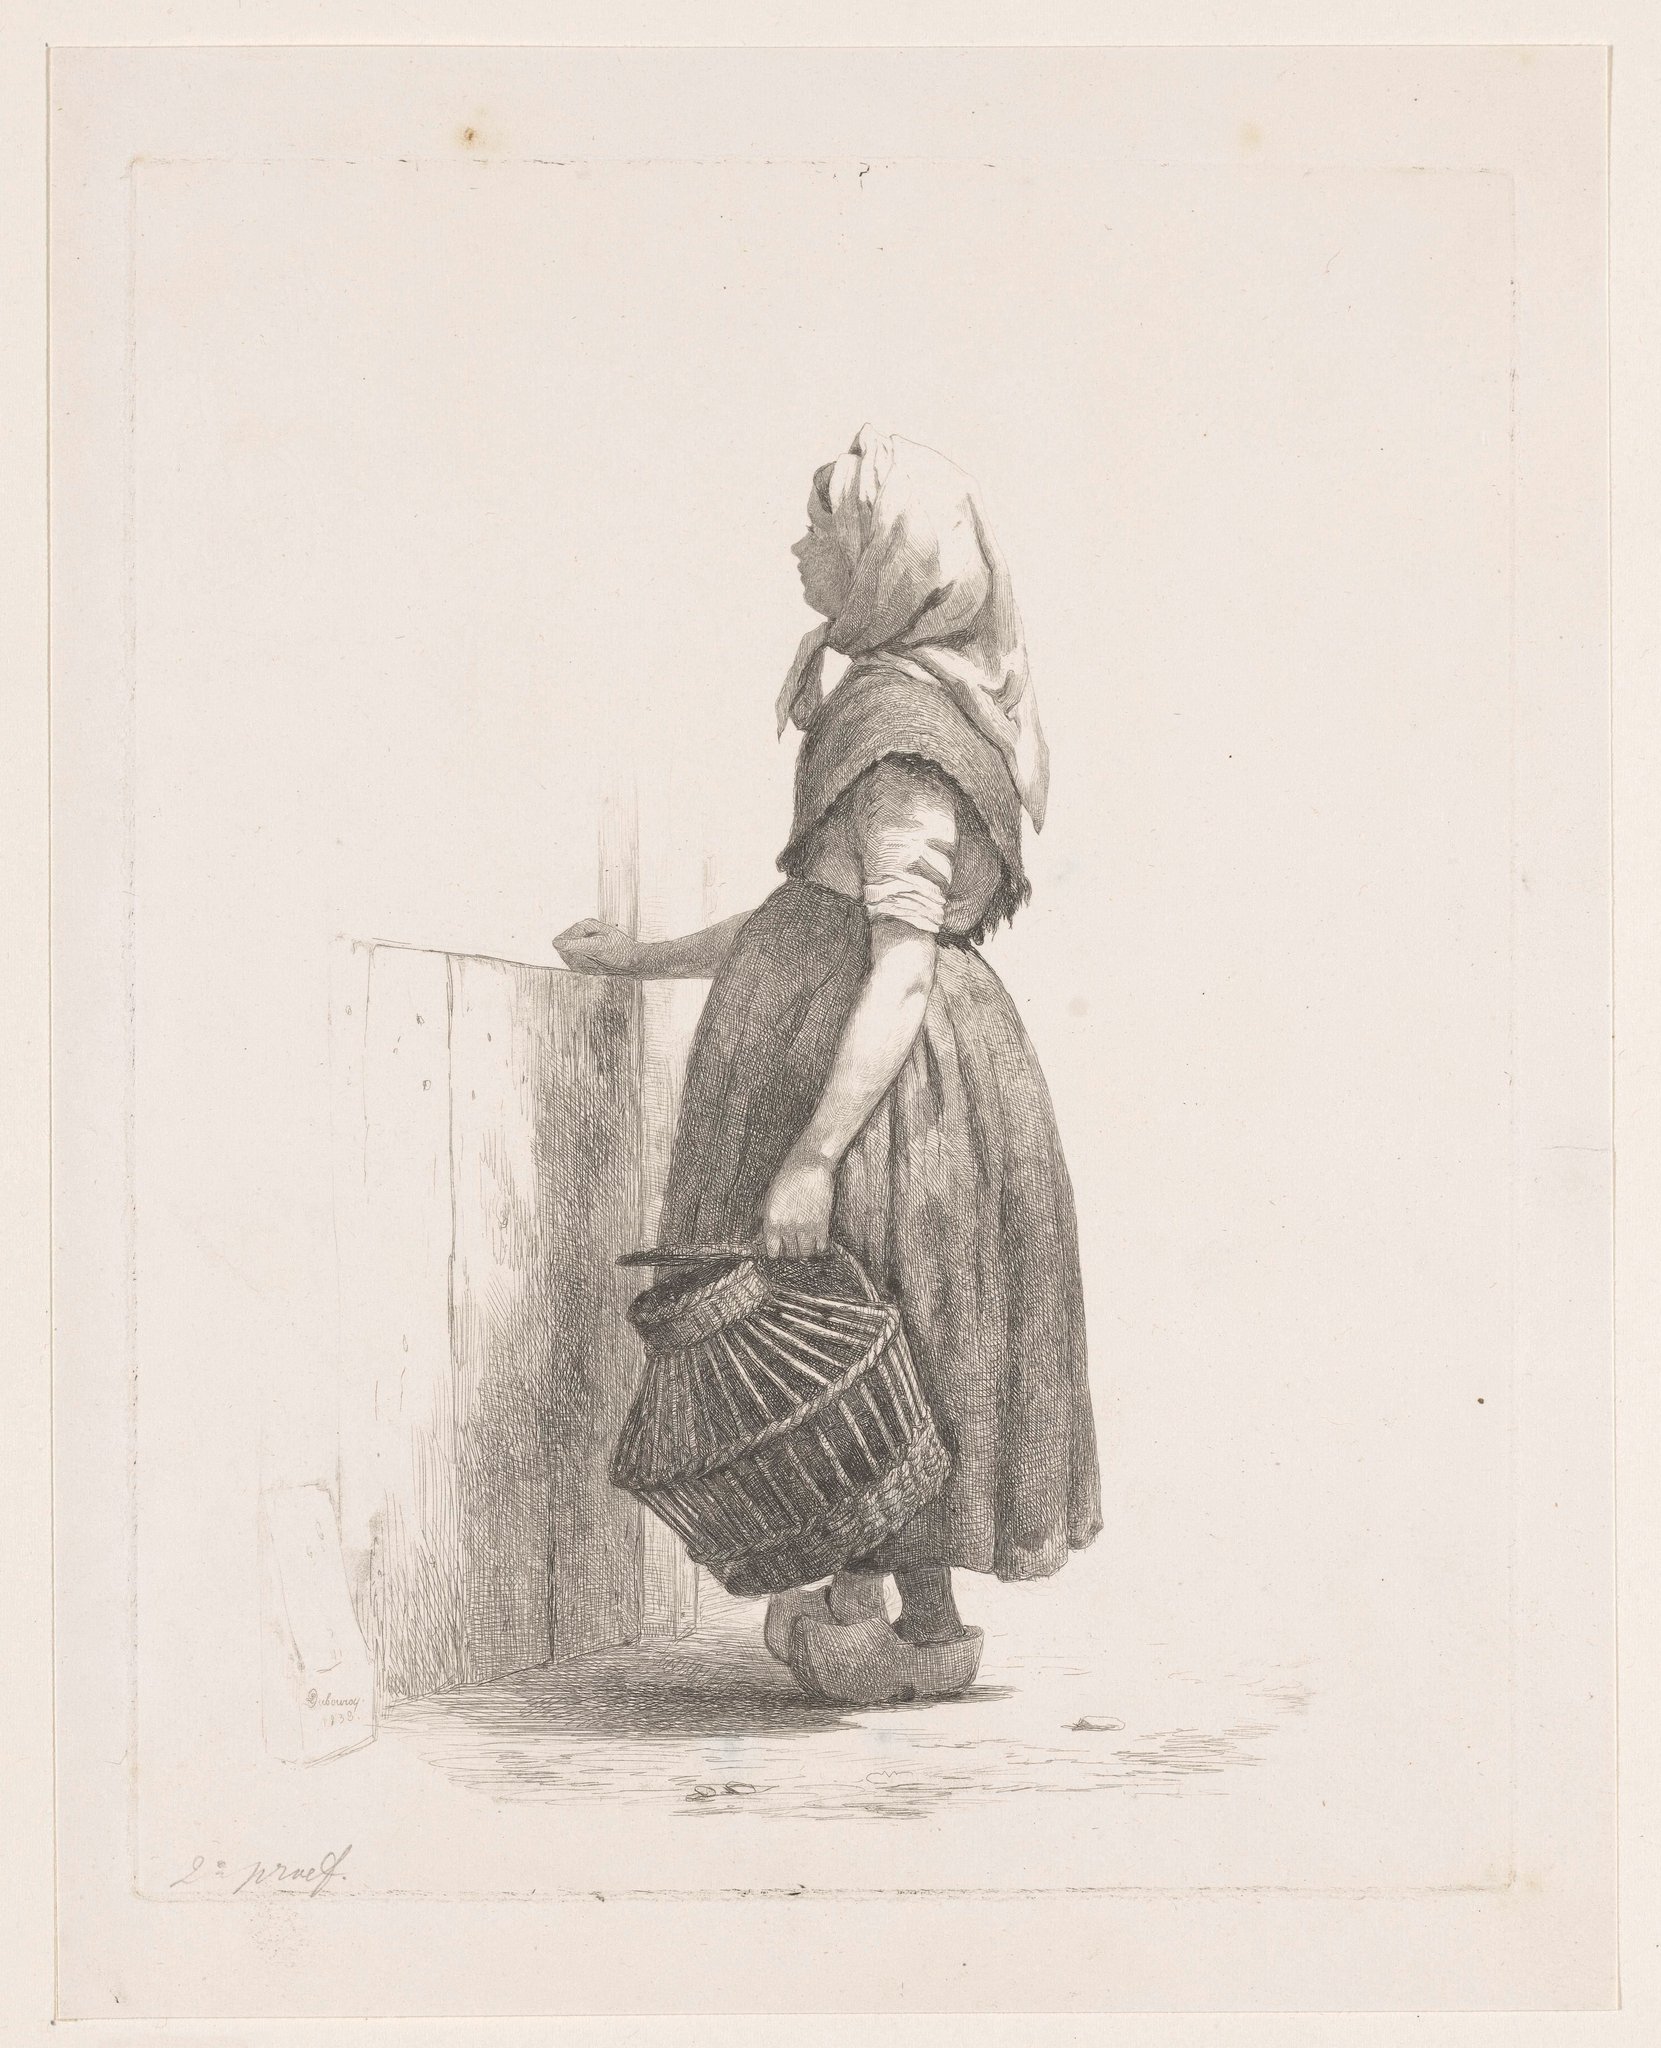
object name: print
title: Staand meisje met pluimveemand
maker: pierre louis dubourcq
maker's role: draughtsman, painter, print maker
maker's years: 1815-1873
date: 1838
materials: paper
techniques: drypoint, etching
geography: netherlands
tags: fowl (cock, hen, chicken, etc.) (+ animal cage)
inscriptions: collector's mark: Lugt 2228